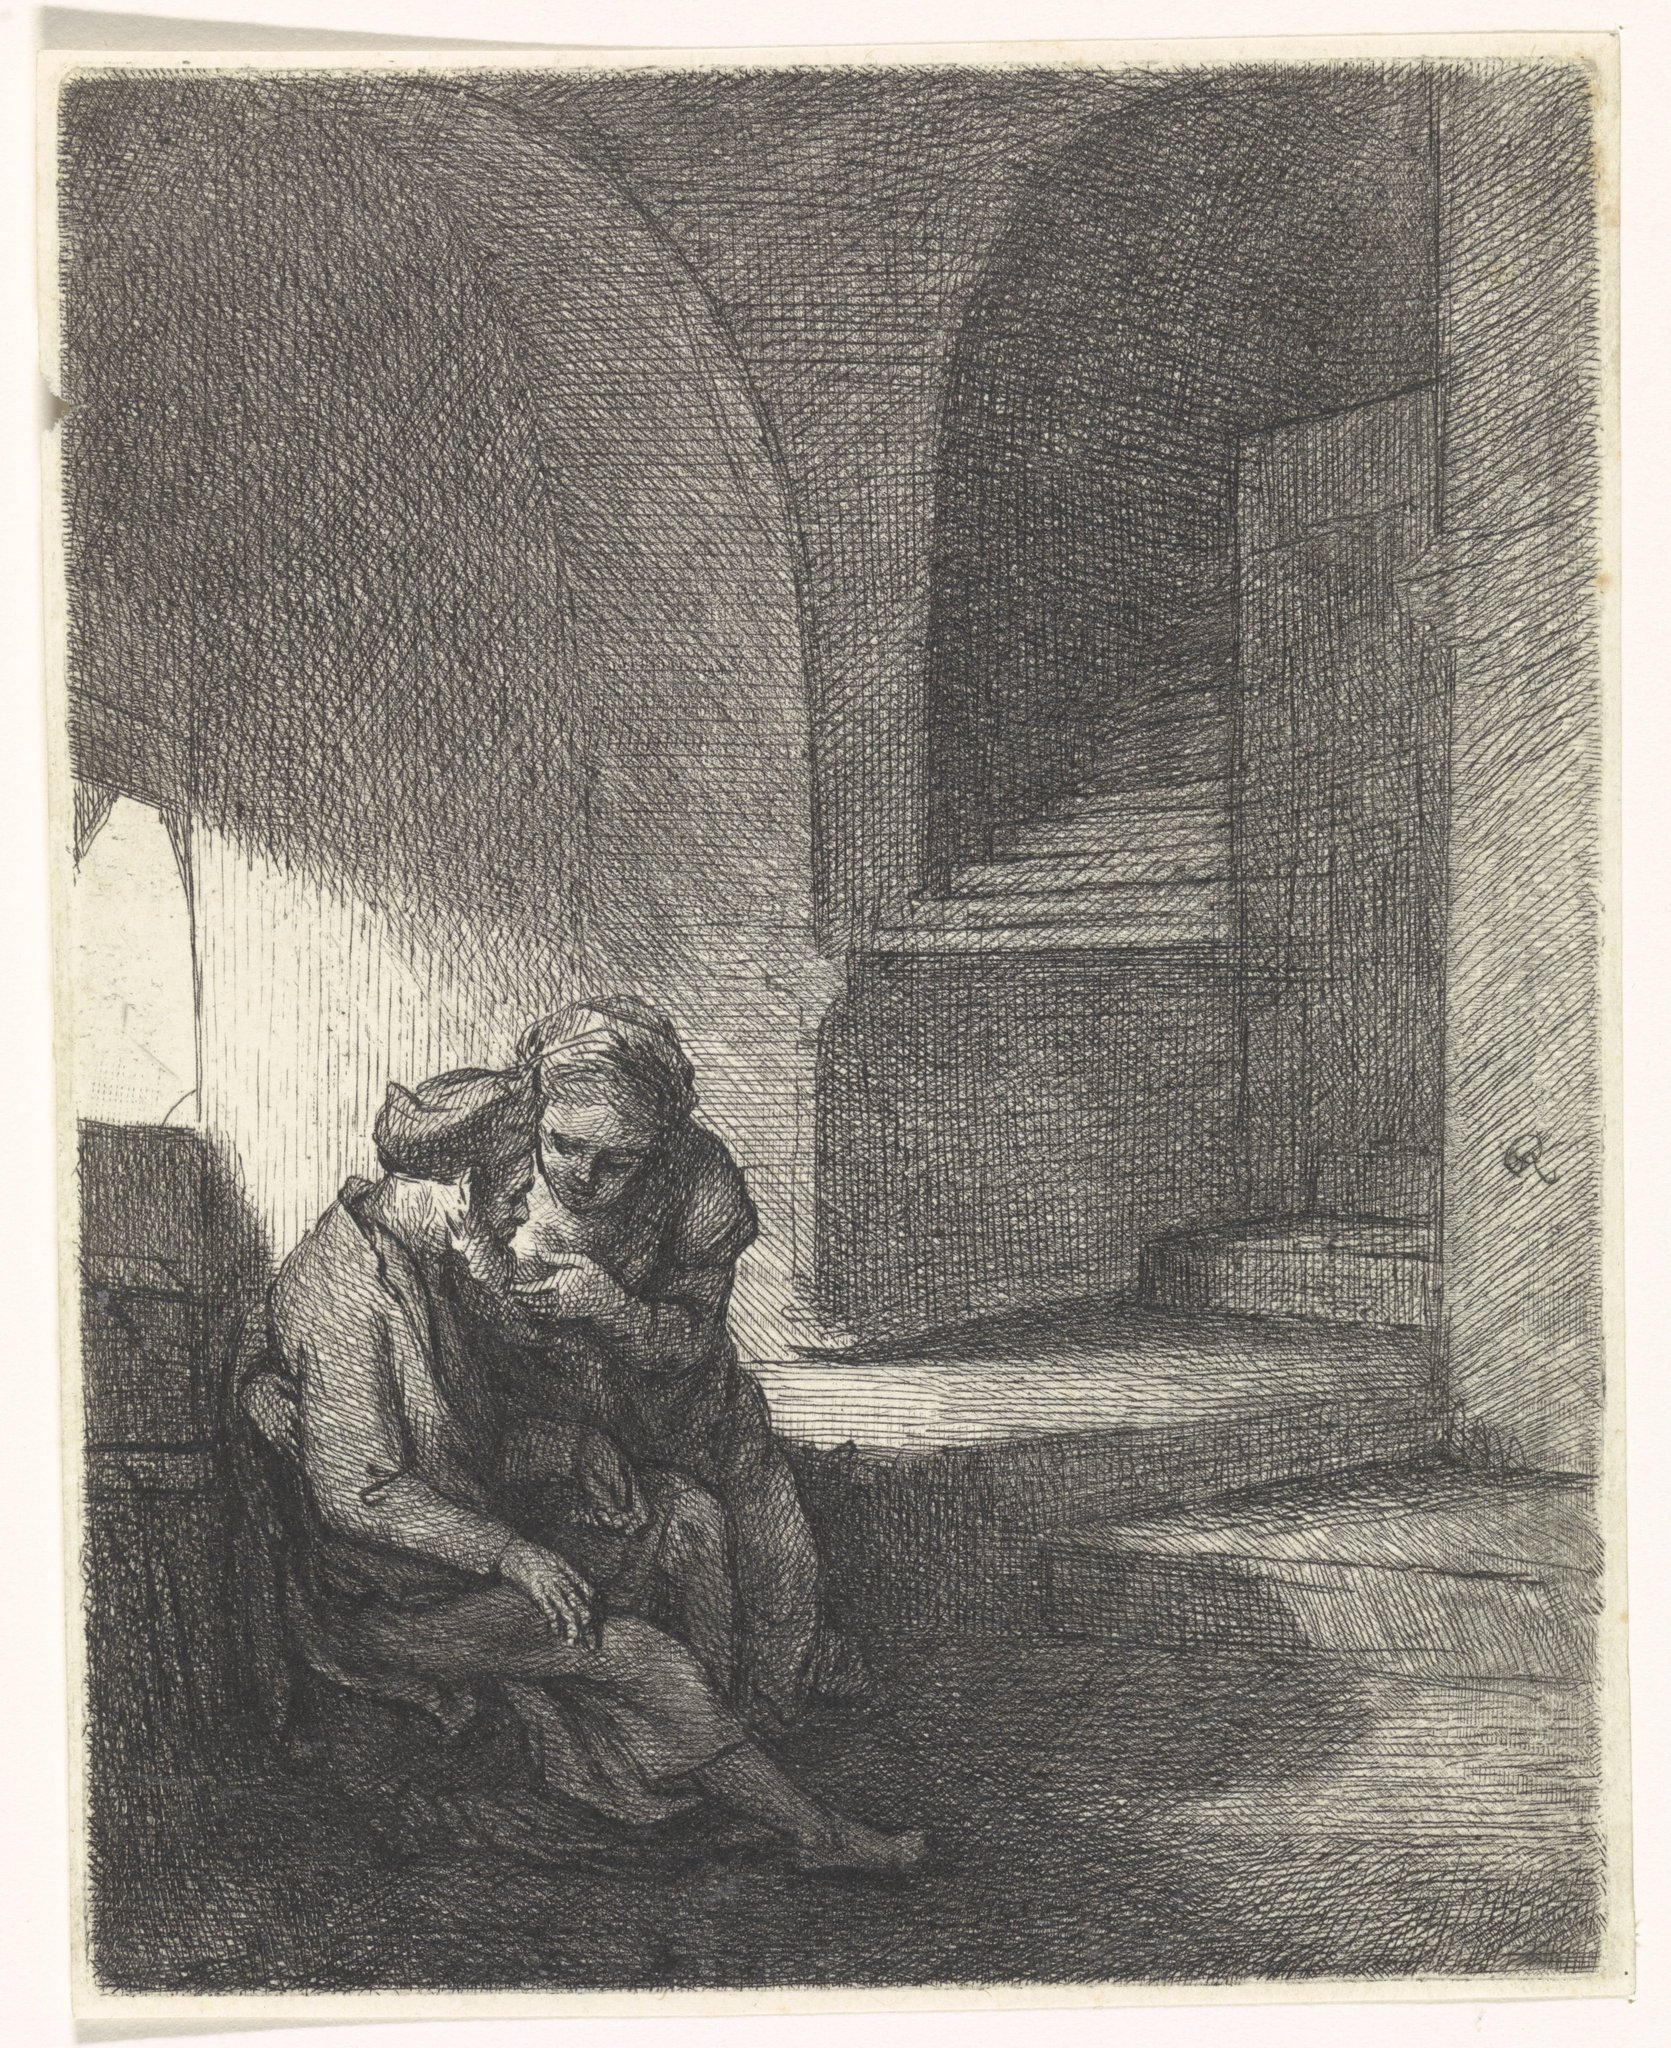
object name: print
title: Pero zoogt de geketende Cimon in de gevangenis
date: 1683-1733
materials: paper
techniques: etching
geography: amsterdam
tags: pero suckling cimon ('caritas romana')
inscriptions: collector's mark: Lugt 240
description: Definitieve geletterde staat van deze prent opgenomen in: Impostures innocentes, ou recueil d'estampes d'apres divers peintres (...) par Bernard Picart (...) avec son elogue historique et le catalogue de ses ouvrages. Amsterdam: weduwe Bernard Picart, 1734.